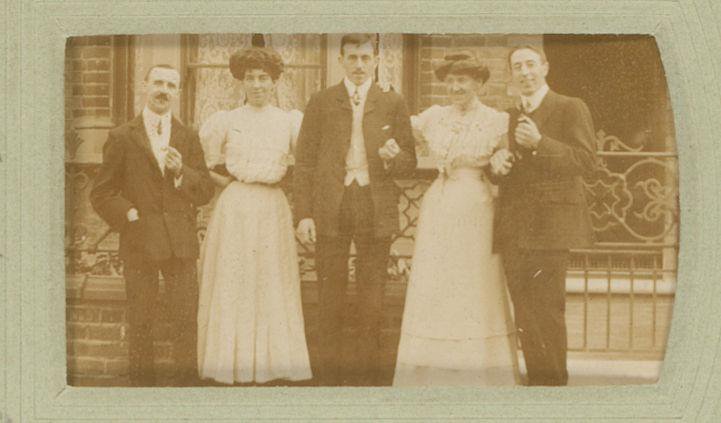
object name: photograph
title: Groepsportret van mannen en vrouwen voor een huis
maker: Anonymous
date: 1890-1910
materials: photographic support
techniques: collodion silver print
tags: adult woman, adult man, civic architecture; edifices; dwellings, anonymous historical persons portrayed in a group, in a group-portrait